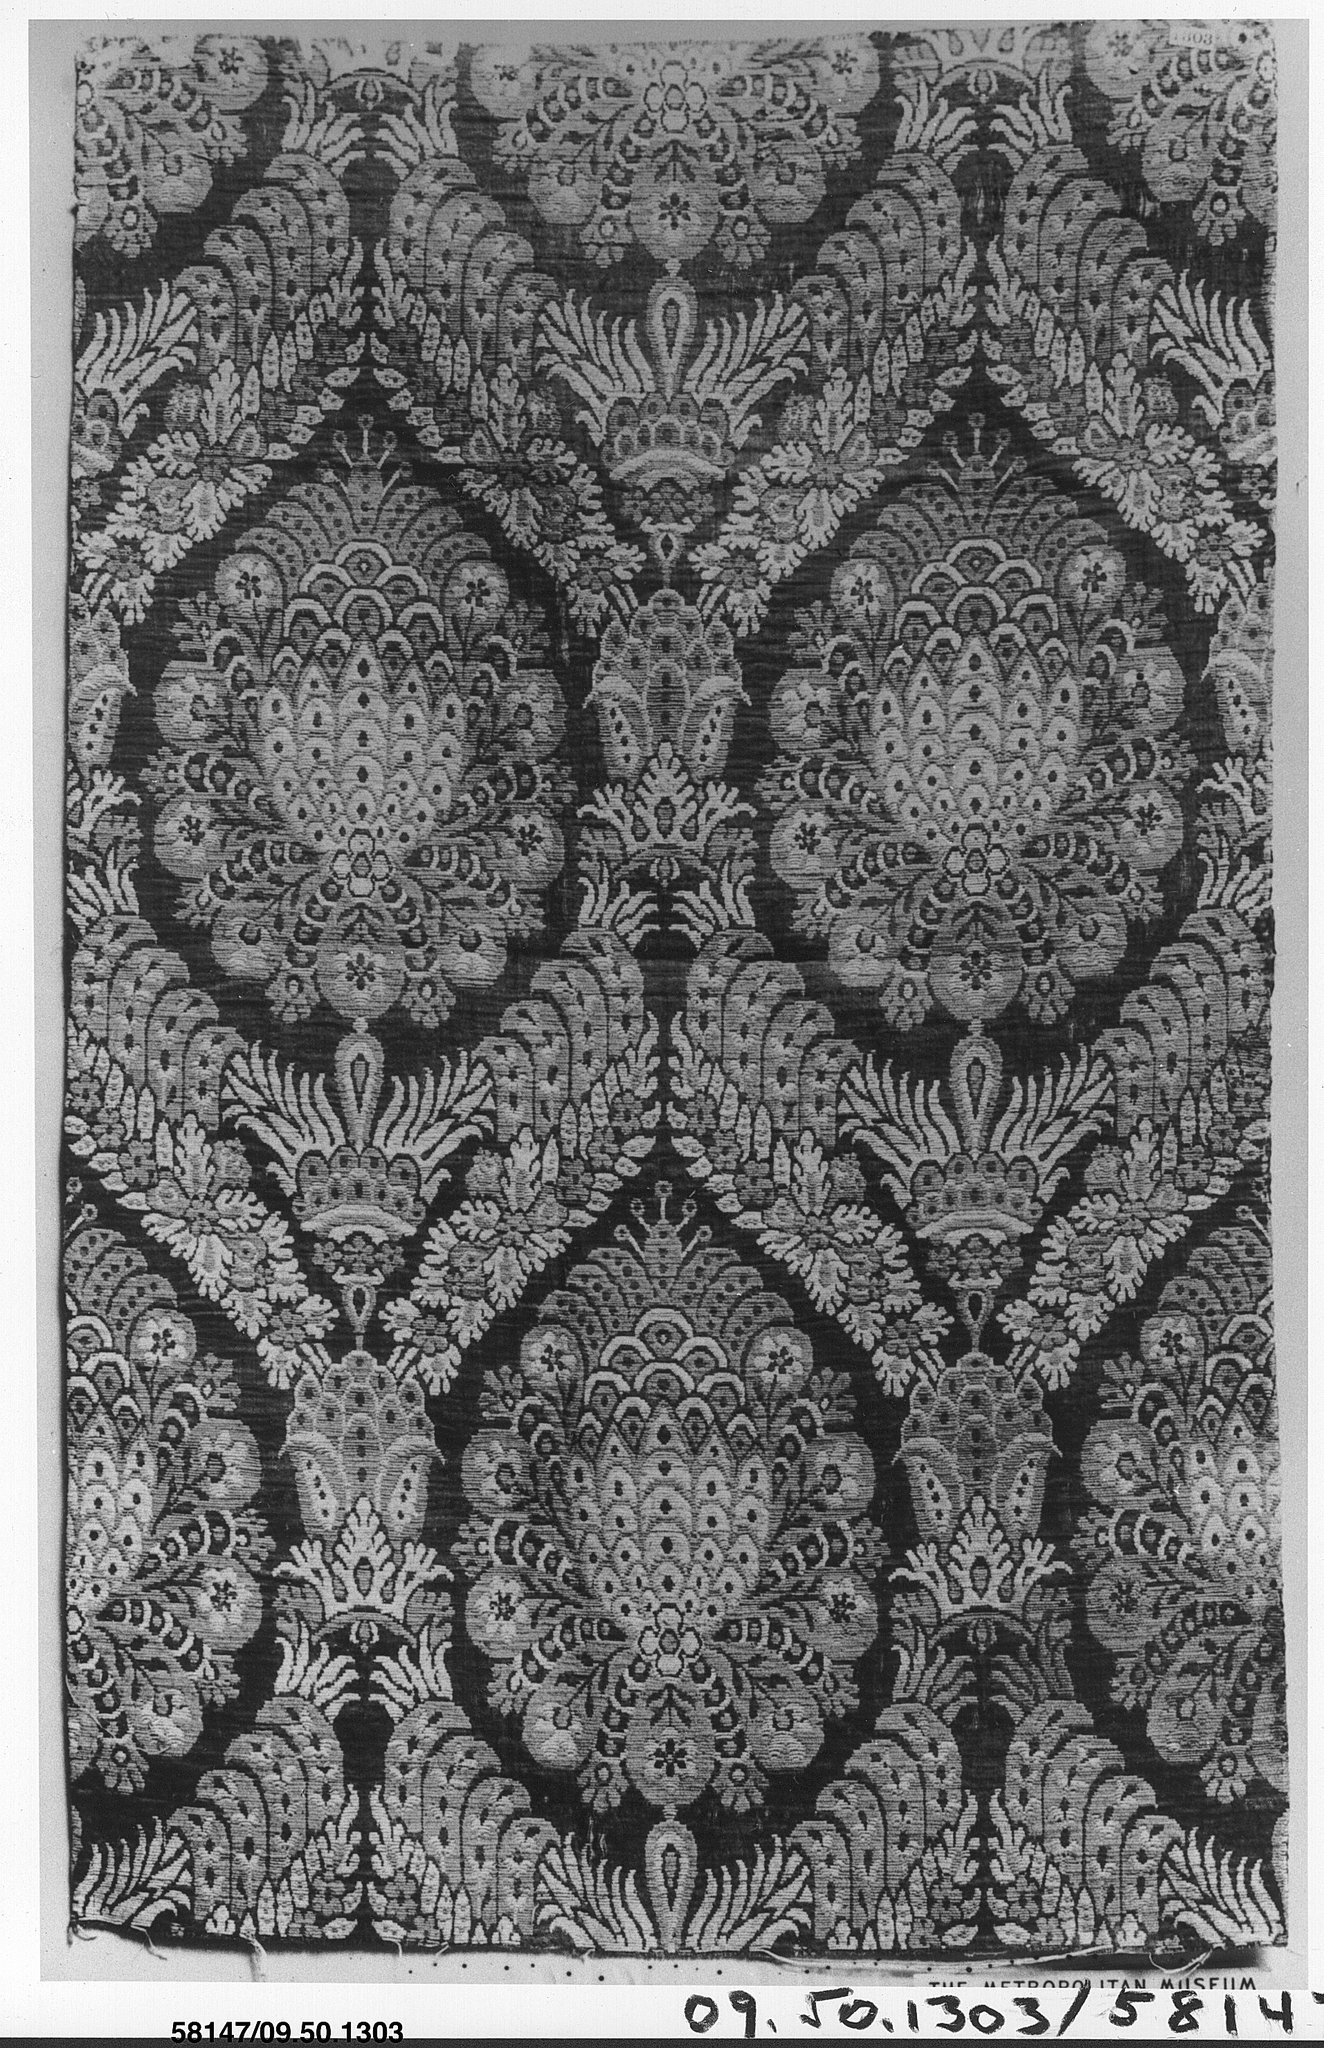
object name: piece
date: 1601-1700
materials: cotton, linen, silk